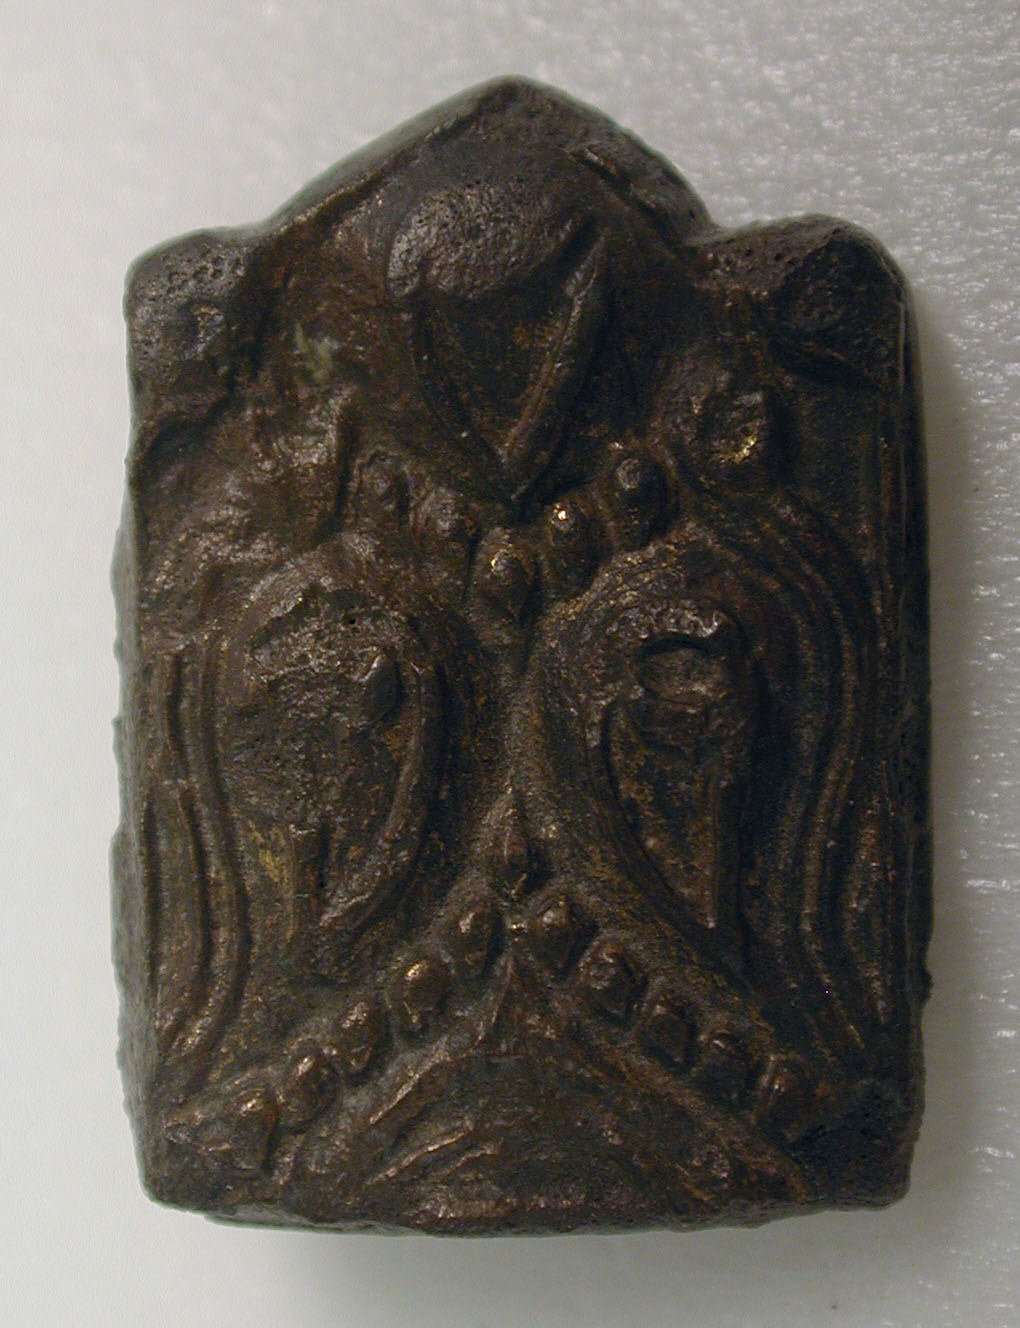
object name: belt fitting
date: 701-1000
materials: bronze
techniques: casting, gilding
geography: iran